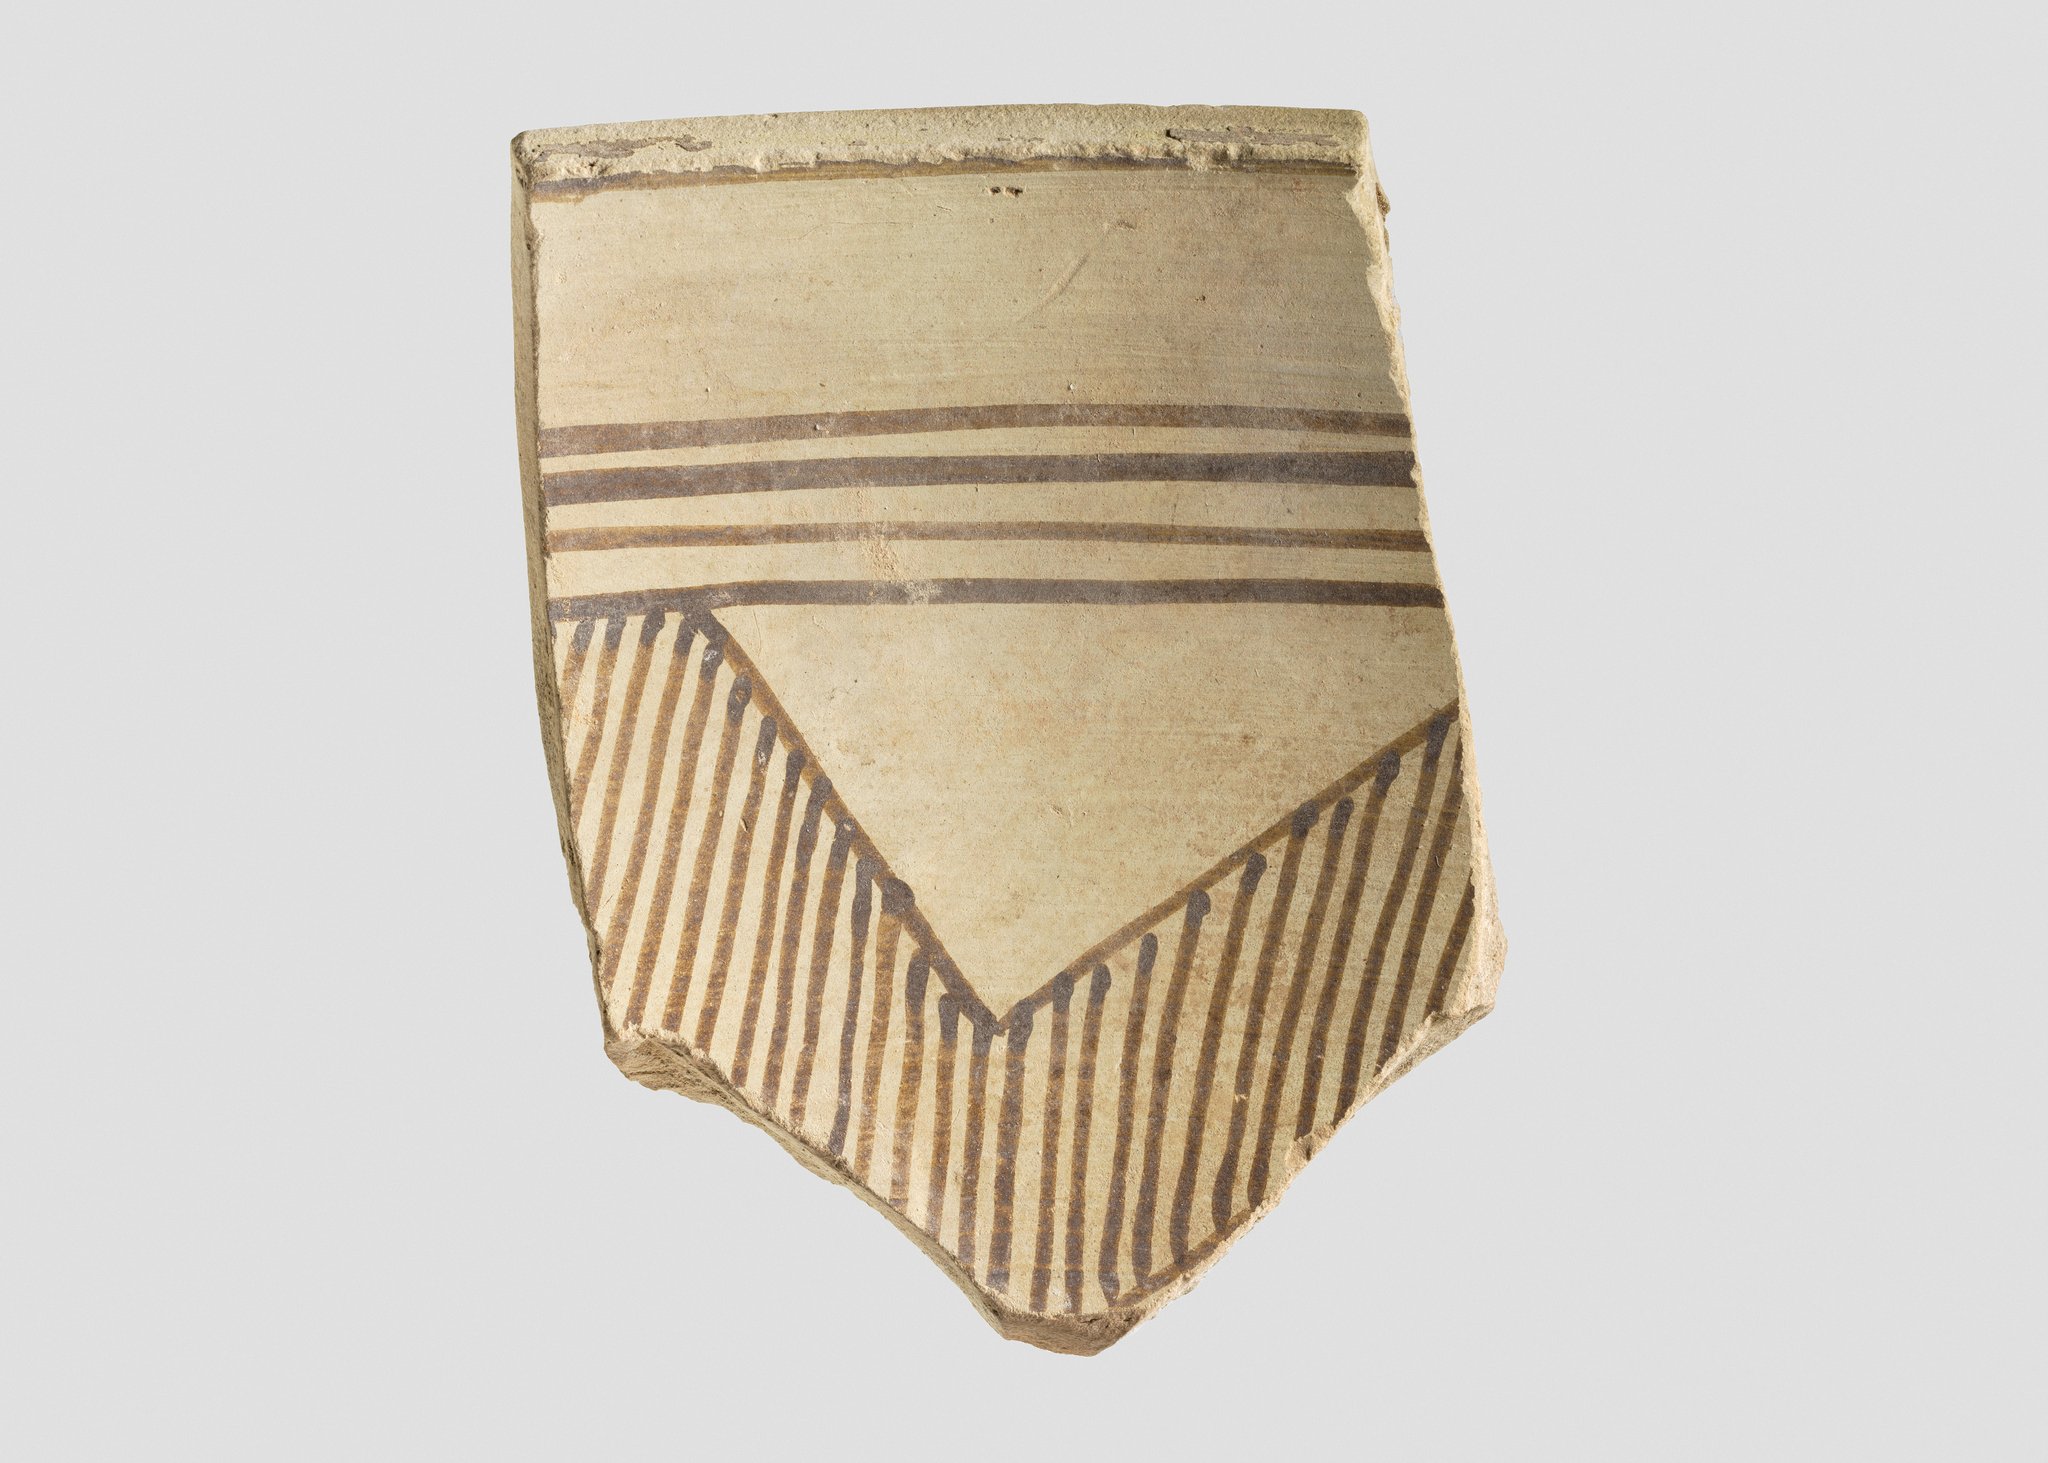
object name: sherd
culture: indus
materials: ceramic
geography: indus region